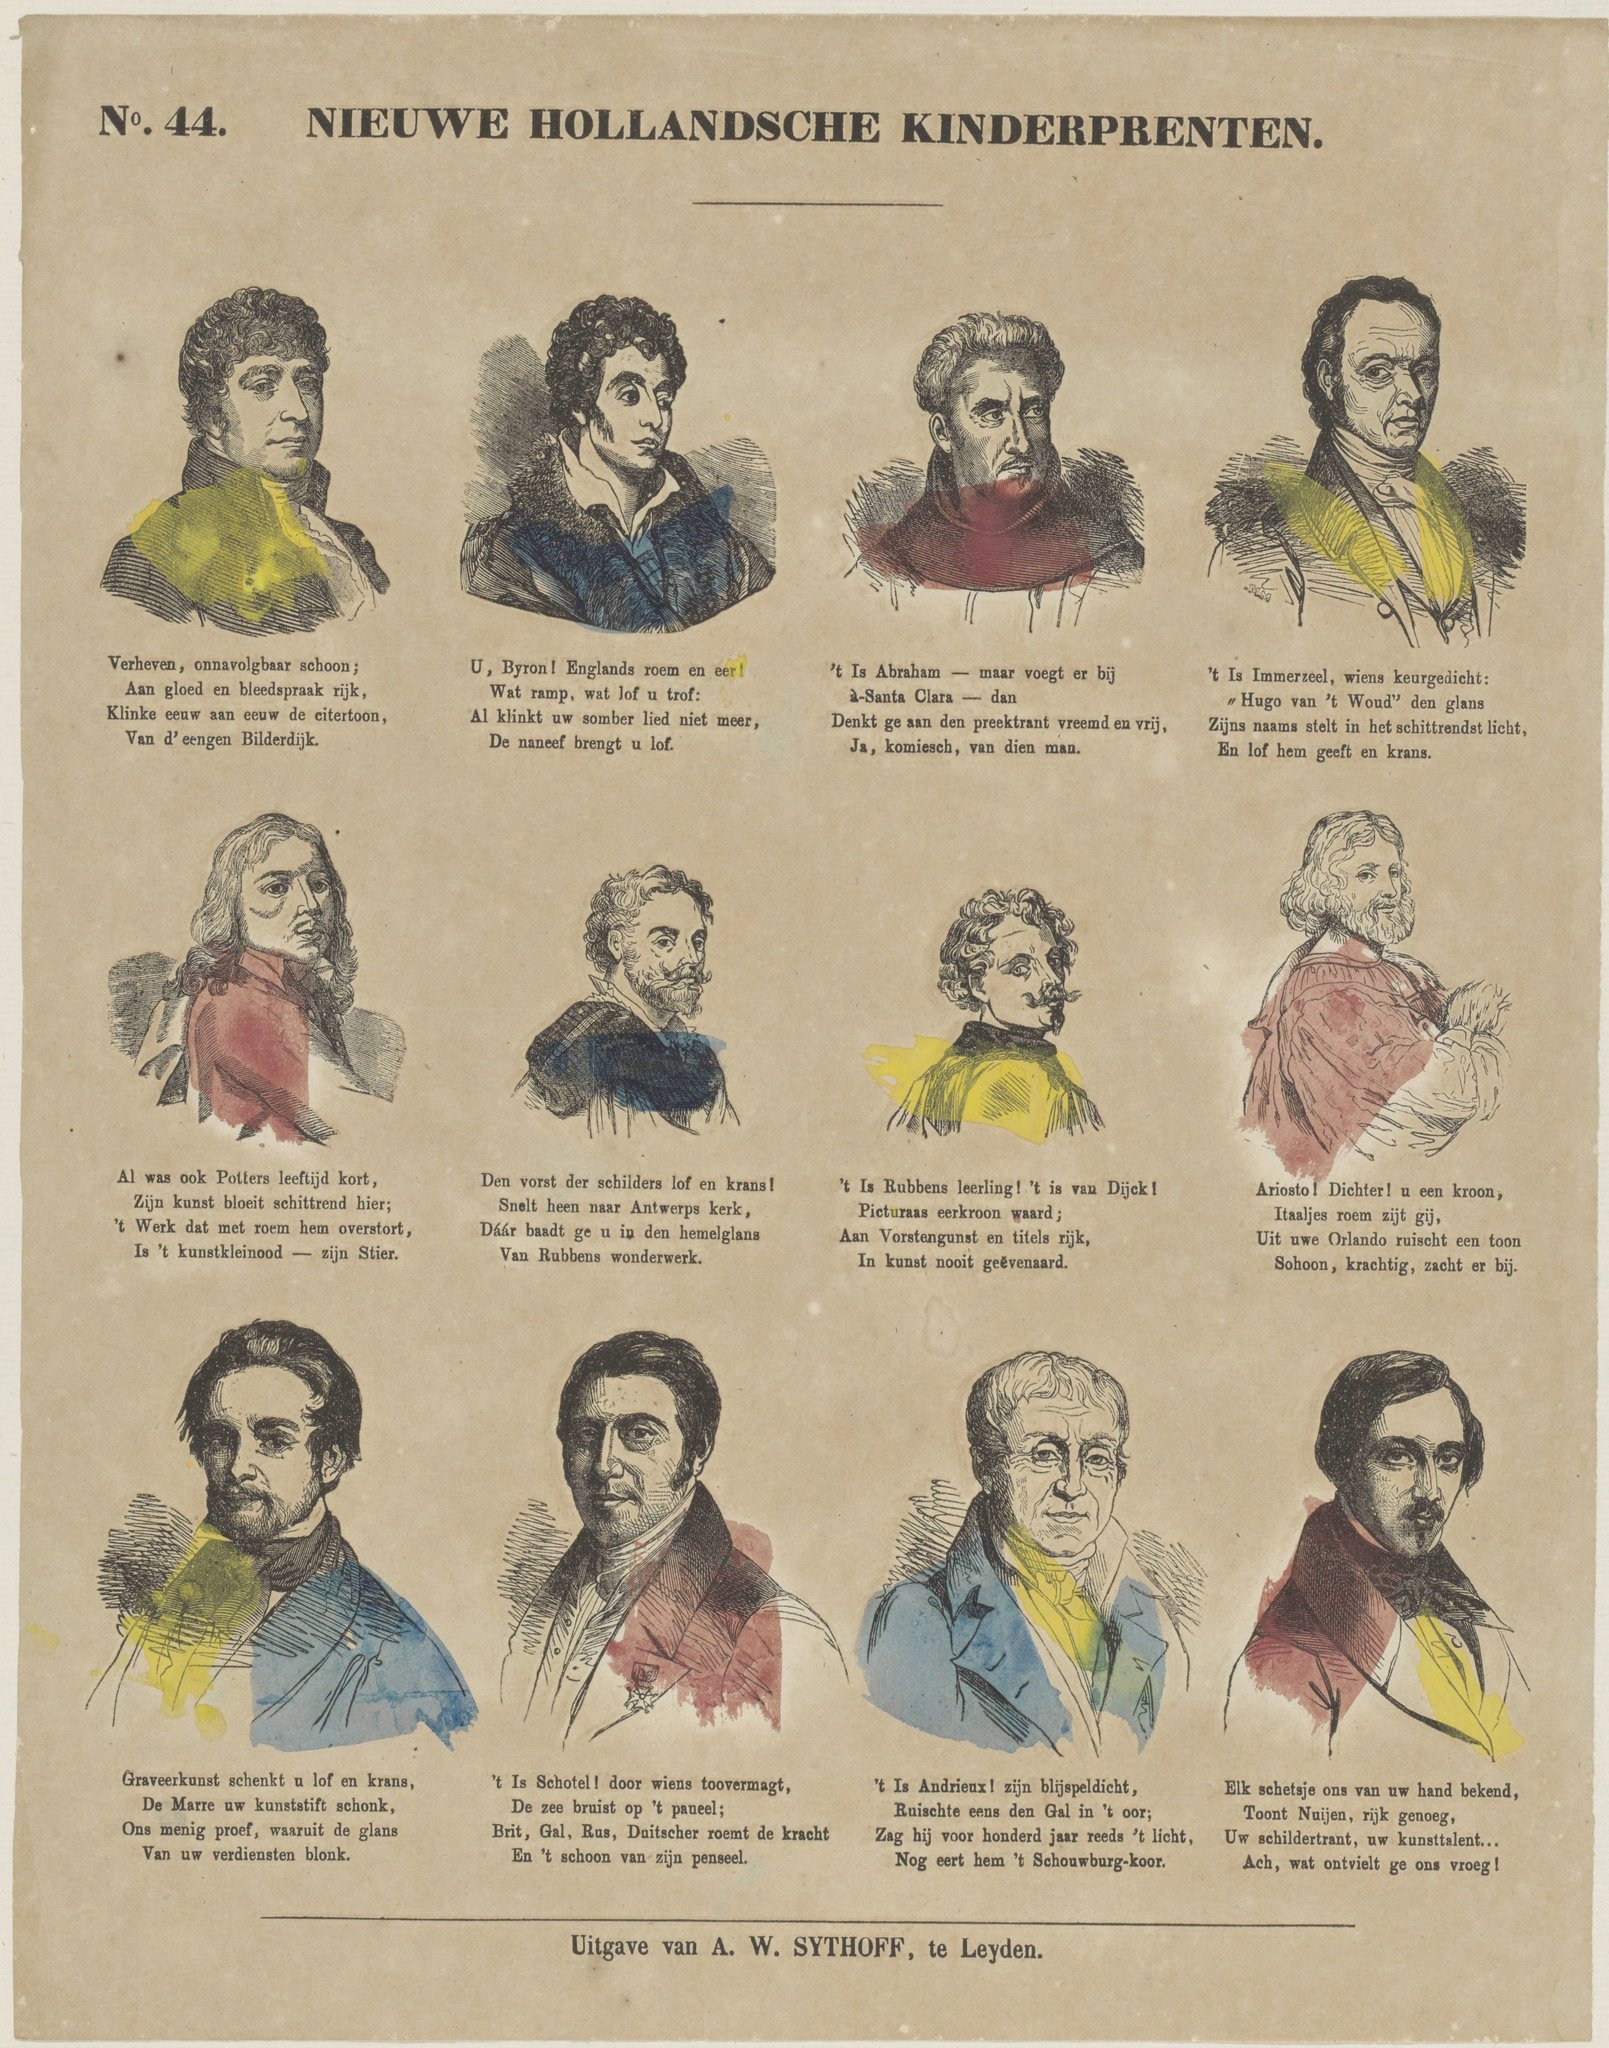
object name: popular print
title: Nieuwe Hollandsche kinderprenten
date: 1861-1929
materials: paper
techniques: colour, letterpress printing, engraving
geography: leiden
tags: the hague, wijnand nuijen, publisher, johannes immerzeel, amsterdam, haarlem, print maker, draughtsman, willem bilderdijk, enkhuizen, paulus potter, johannes christiaan schotel, peter paul rubens, antwerp, london, painter, anthony van dyck, lord byron, ludovico ariosto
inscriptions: collector's mark: Lugt 2760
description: Blad met 12 portretten van schilders en schrijvers, onder wie Willem Bilderdijk, Paulus Potter en Peter Paul Rubens. Onder elke voorstelling een vierregelig vers. Genummerd linksboven: No. 44.